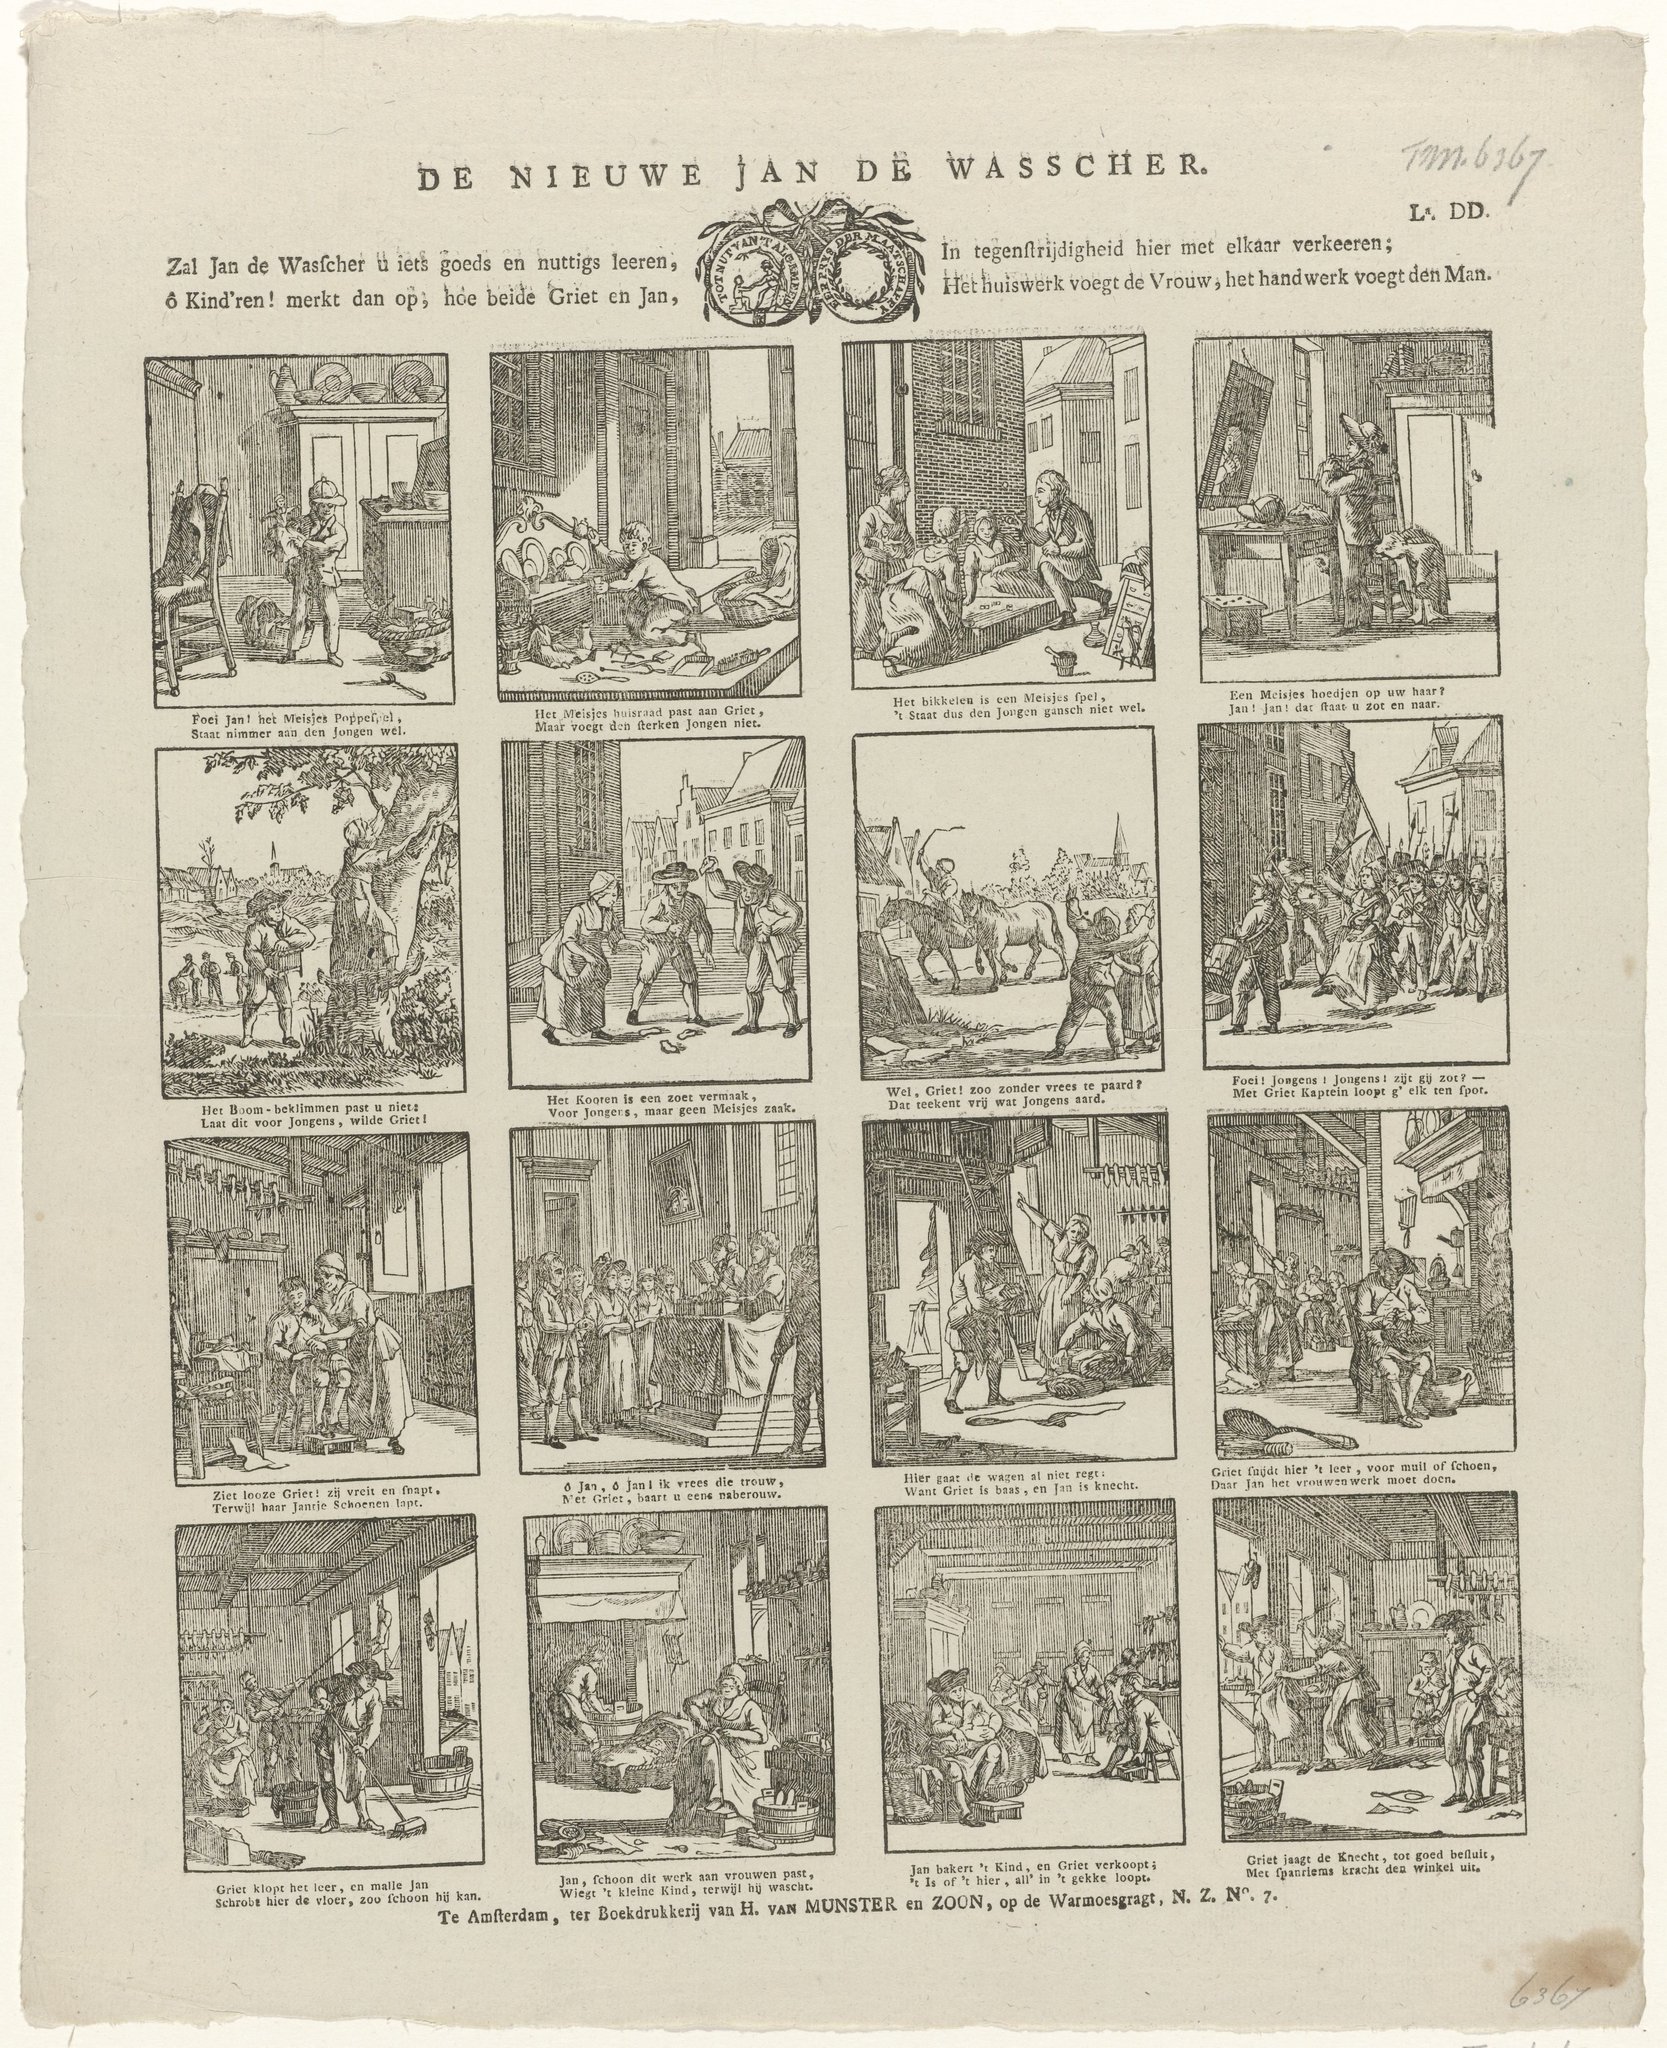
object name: popular print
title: De Nieuwe Jan de Wasscher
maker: Anonymous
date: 1840-1899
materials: paper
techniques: letterpress printing, engraving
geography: amsterdam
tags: hen-pecked husband, 'betty', 'molly' (man who engages in women's work)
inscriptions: collector's mark: Lugt 2228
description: Blad met zestien voorstellingen van het leven van Jan de Wasscher, een man die van zijn vrouw - die de broek aan heeft - al het huishoudelijk werk moet doen. Onder elk plaatje een tweeregelig versje. Voorzien van het zegel van de Maatschappij Tot Nut van 't Algemeen. Genummerd rechtsboven: La. DD. Ca. 1840-1900.